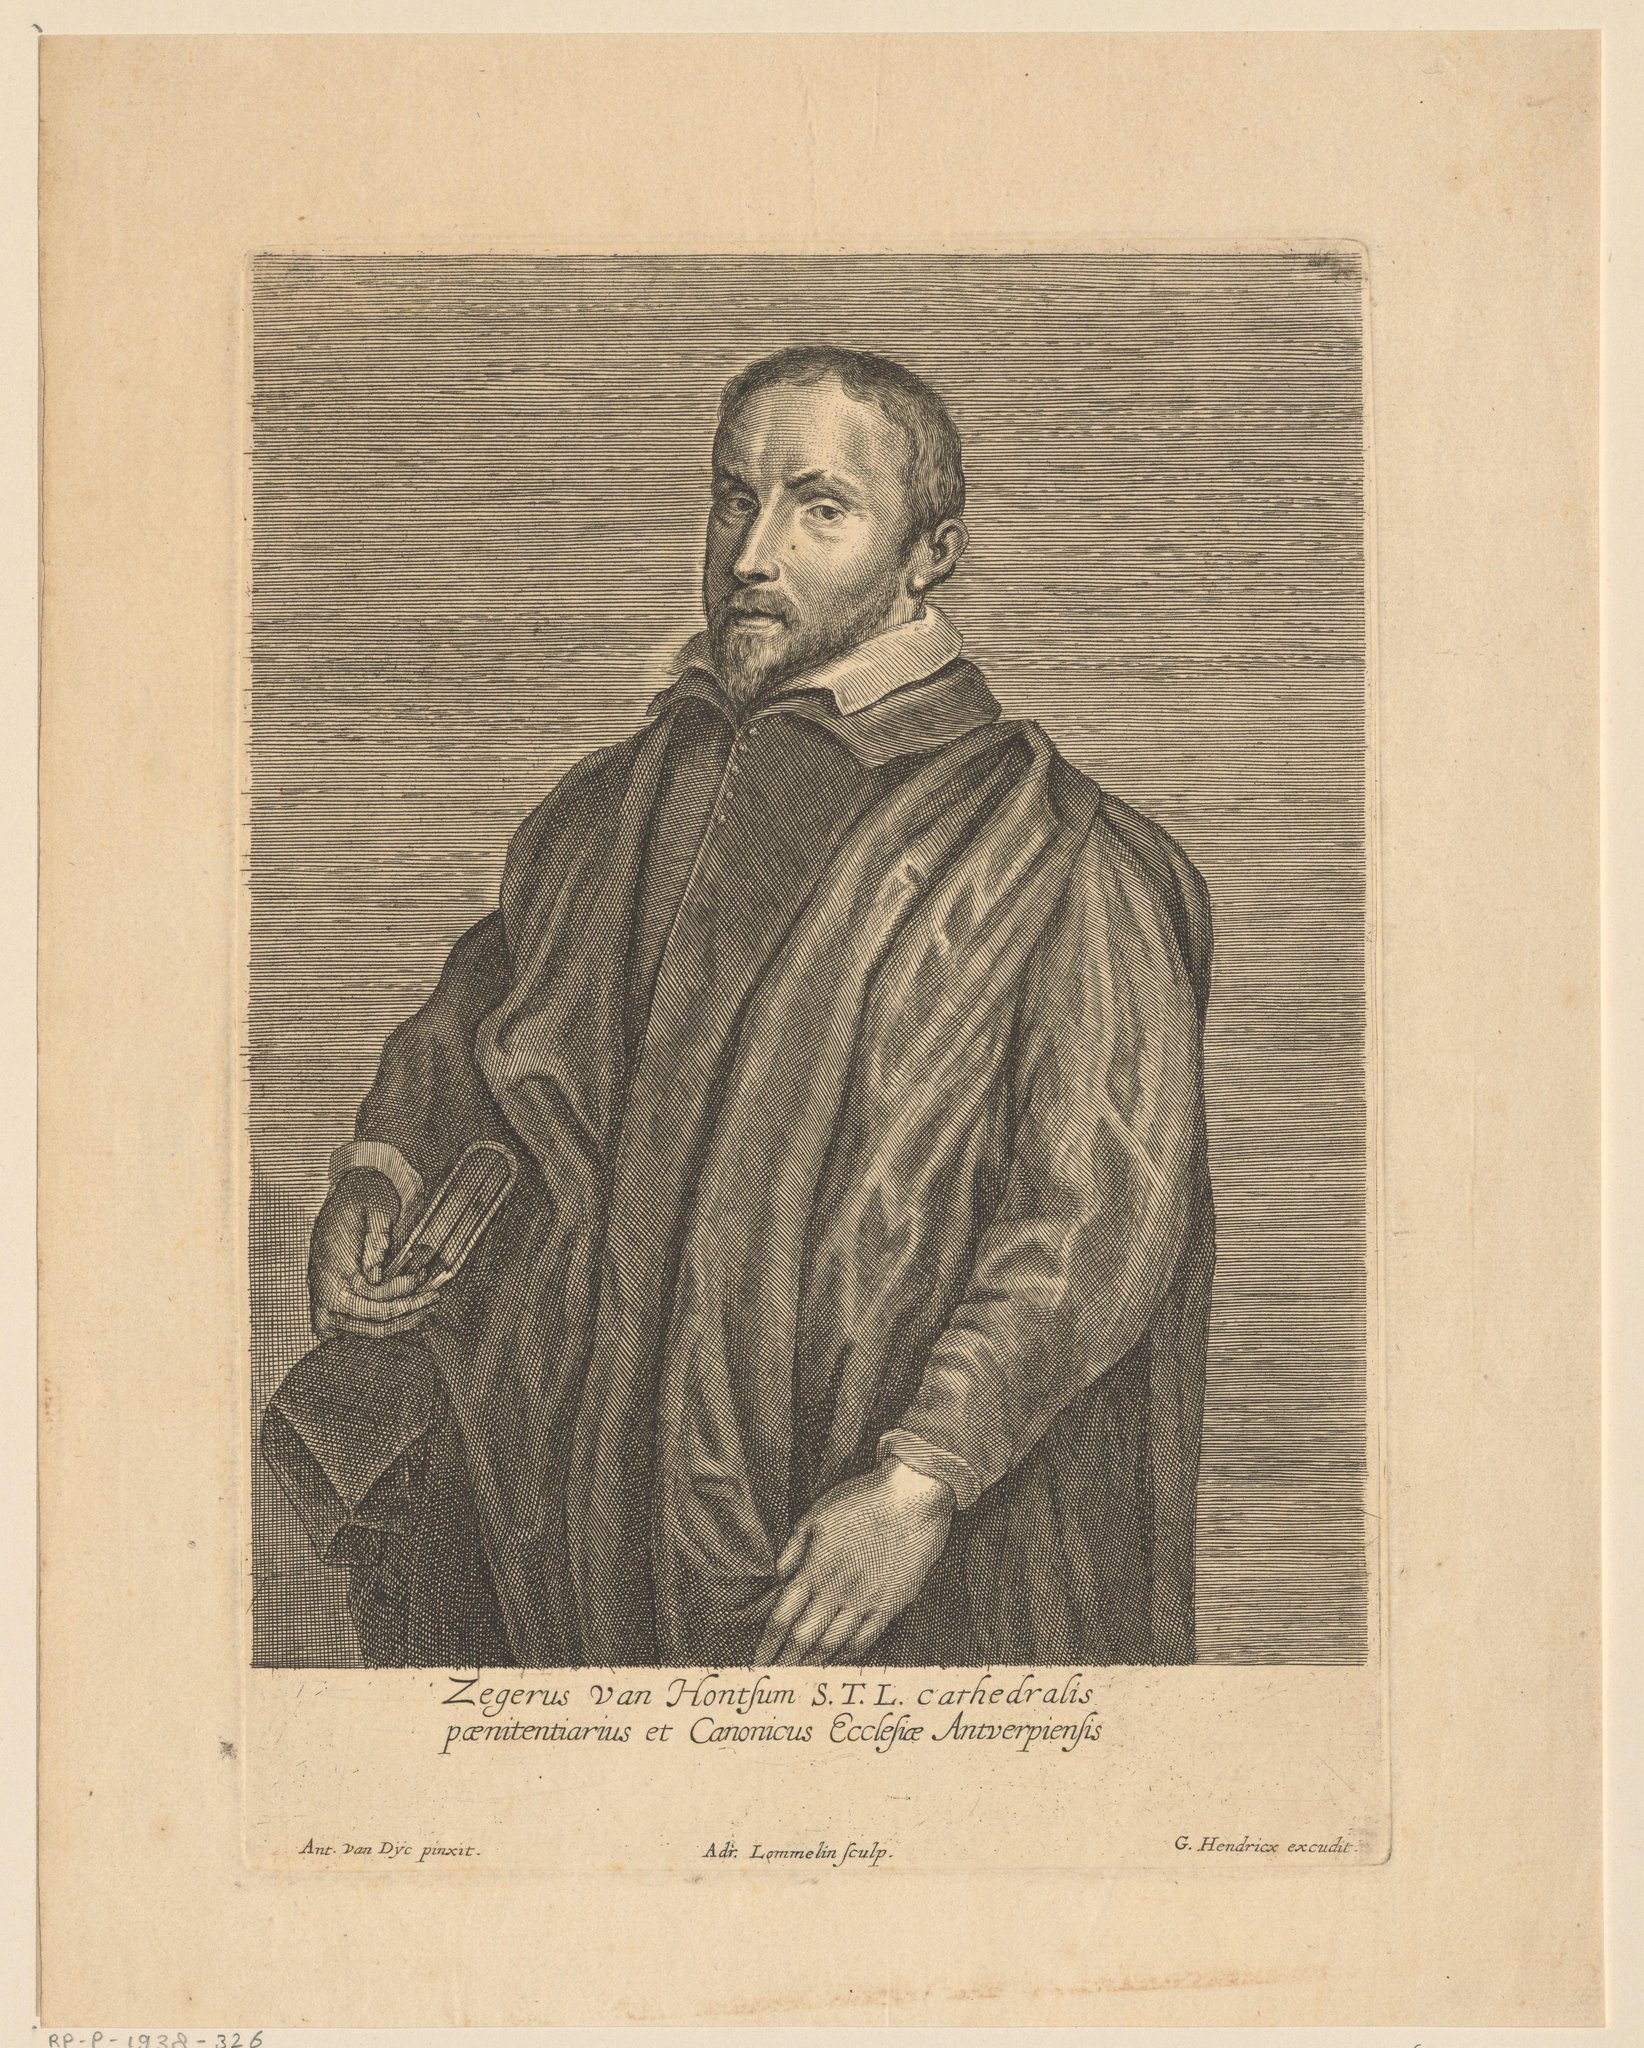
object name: print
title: Portret van Zegerus van Hontsum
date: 1630-1675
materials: paper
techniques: engraving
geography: antwerp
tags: historical persons, book, prelates, e.g. archdeacon, canon (roman catholic)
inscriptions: collector's mark: Lugt 2228